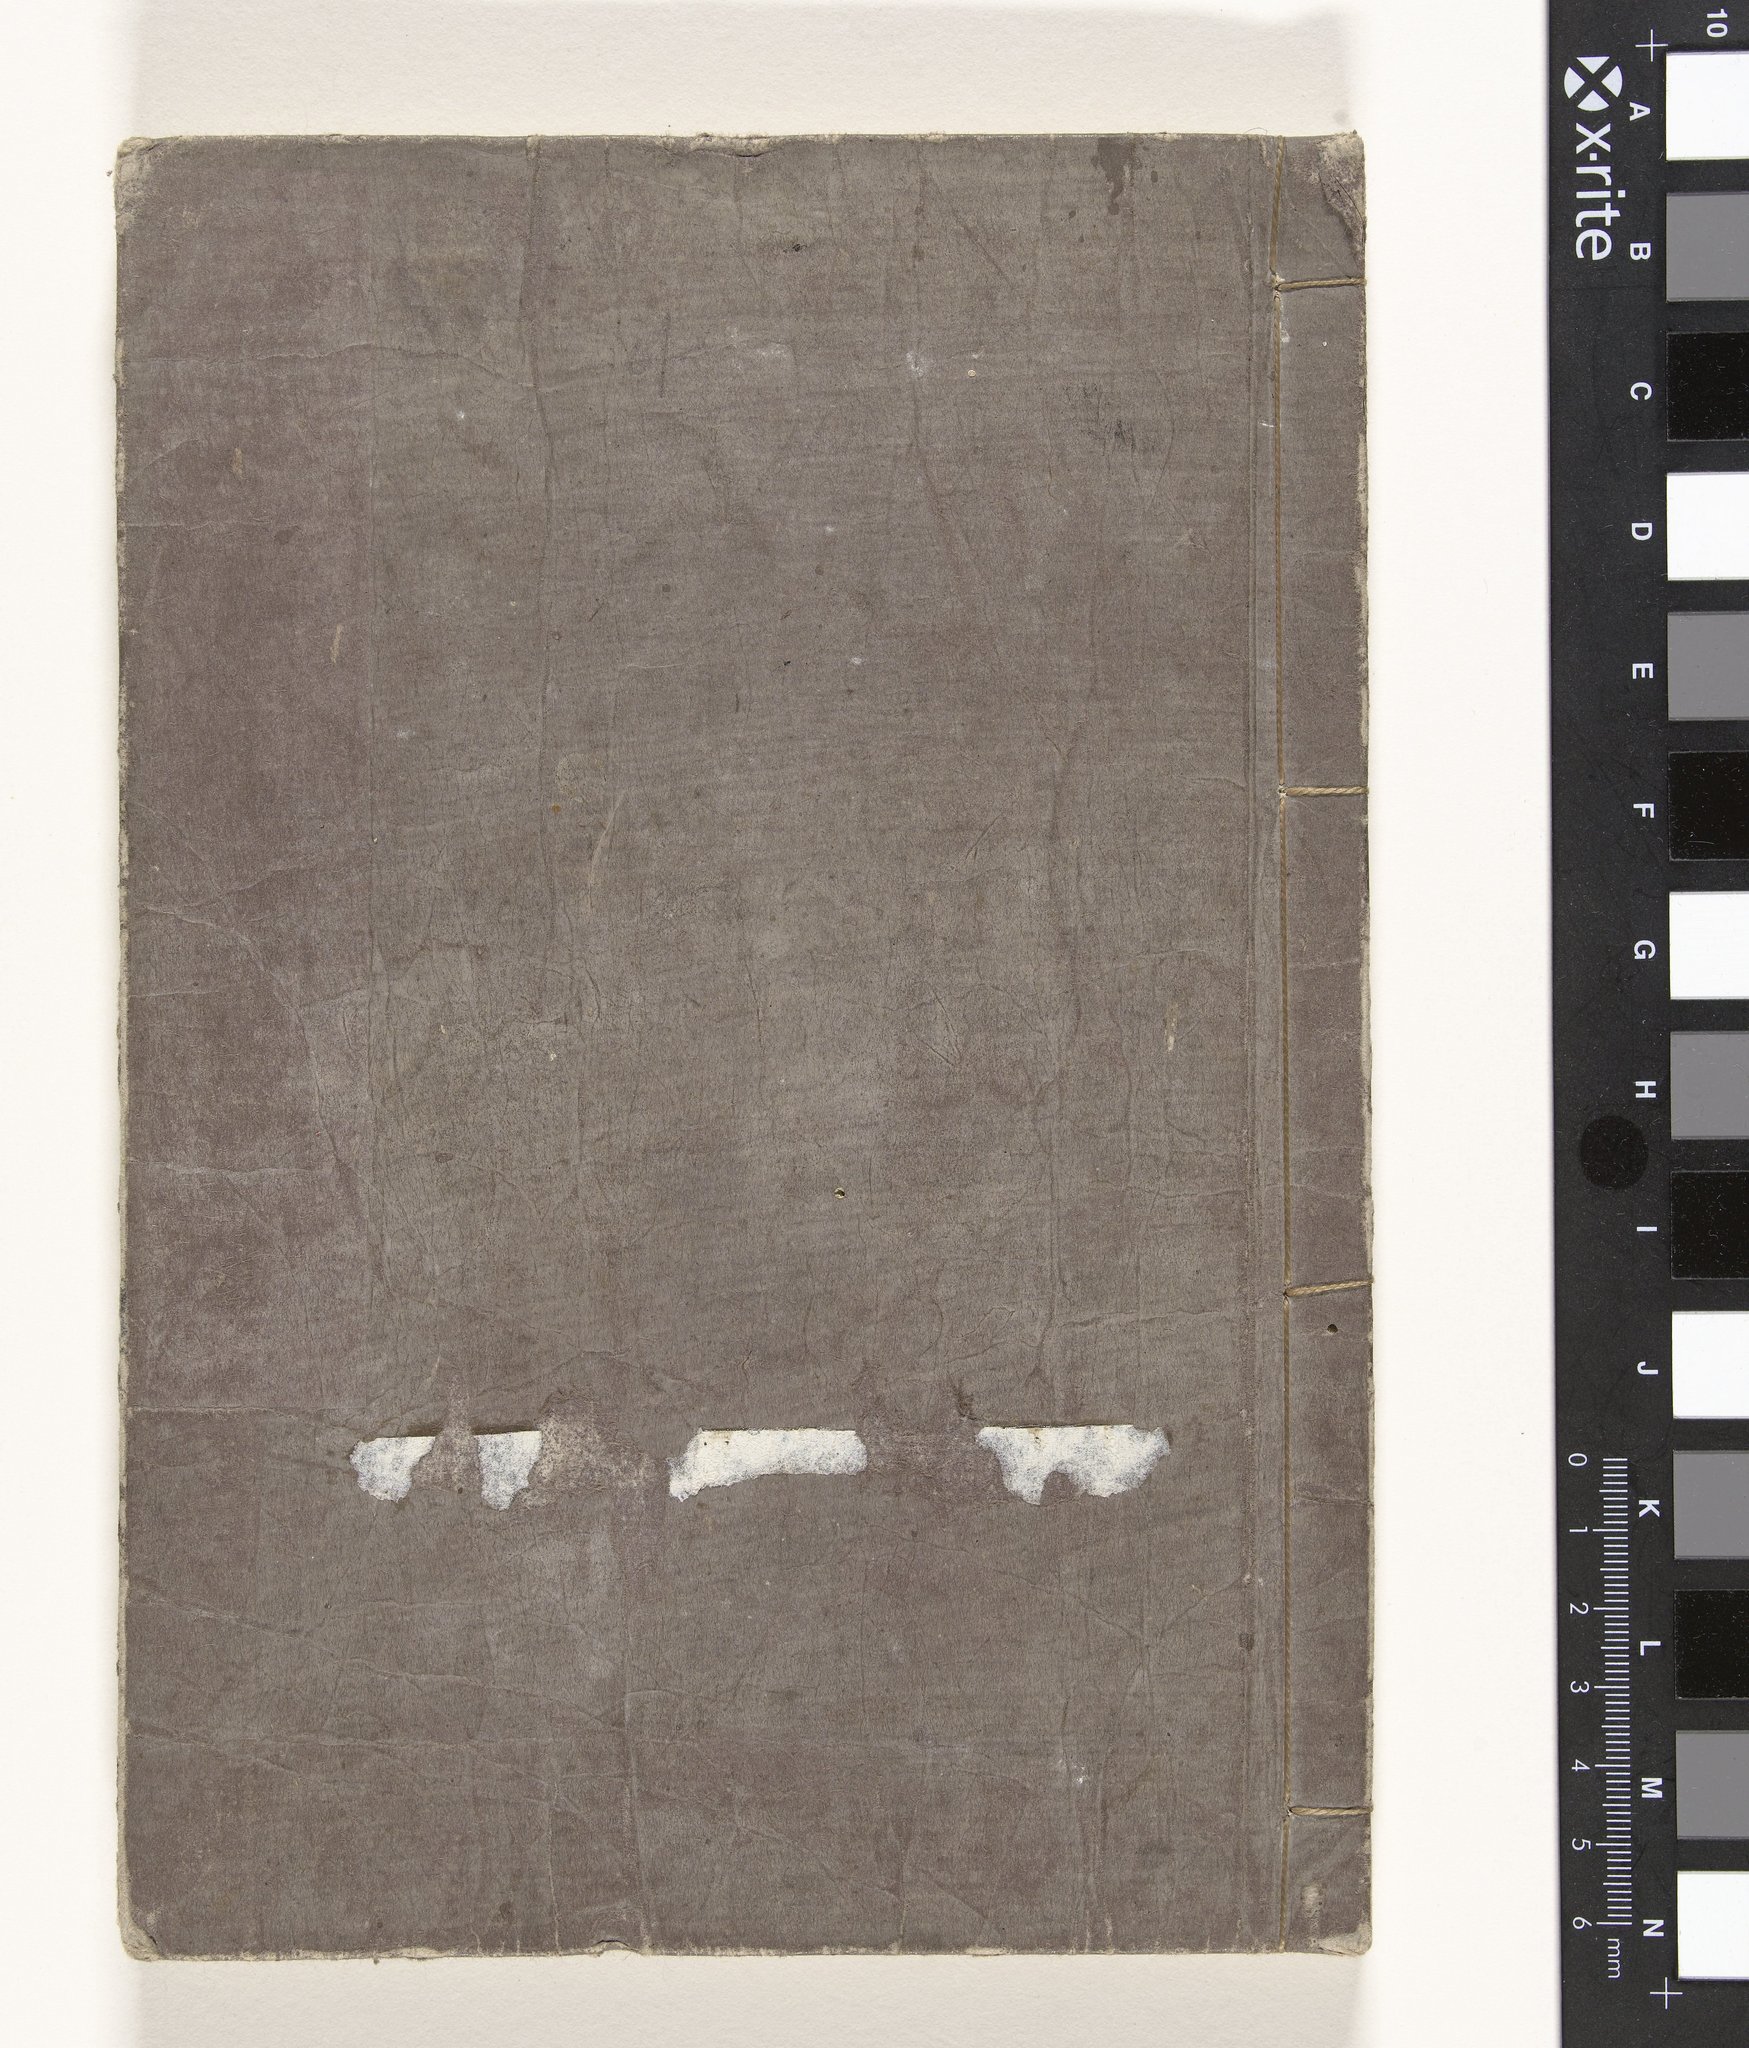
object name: book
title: Ehon sakigake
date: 1836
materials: paper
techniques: woodcut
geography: edo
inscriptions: date